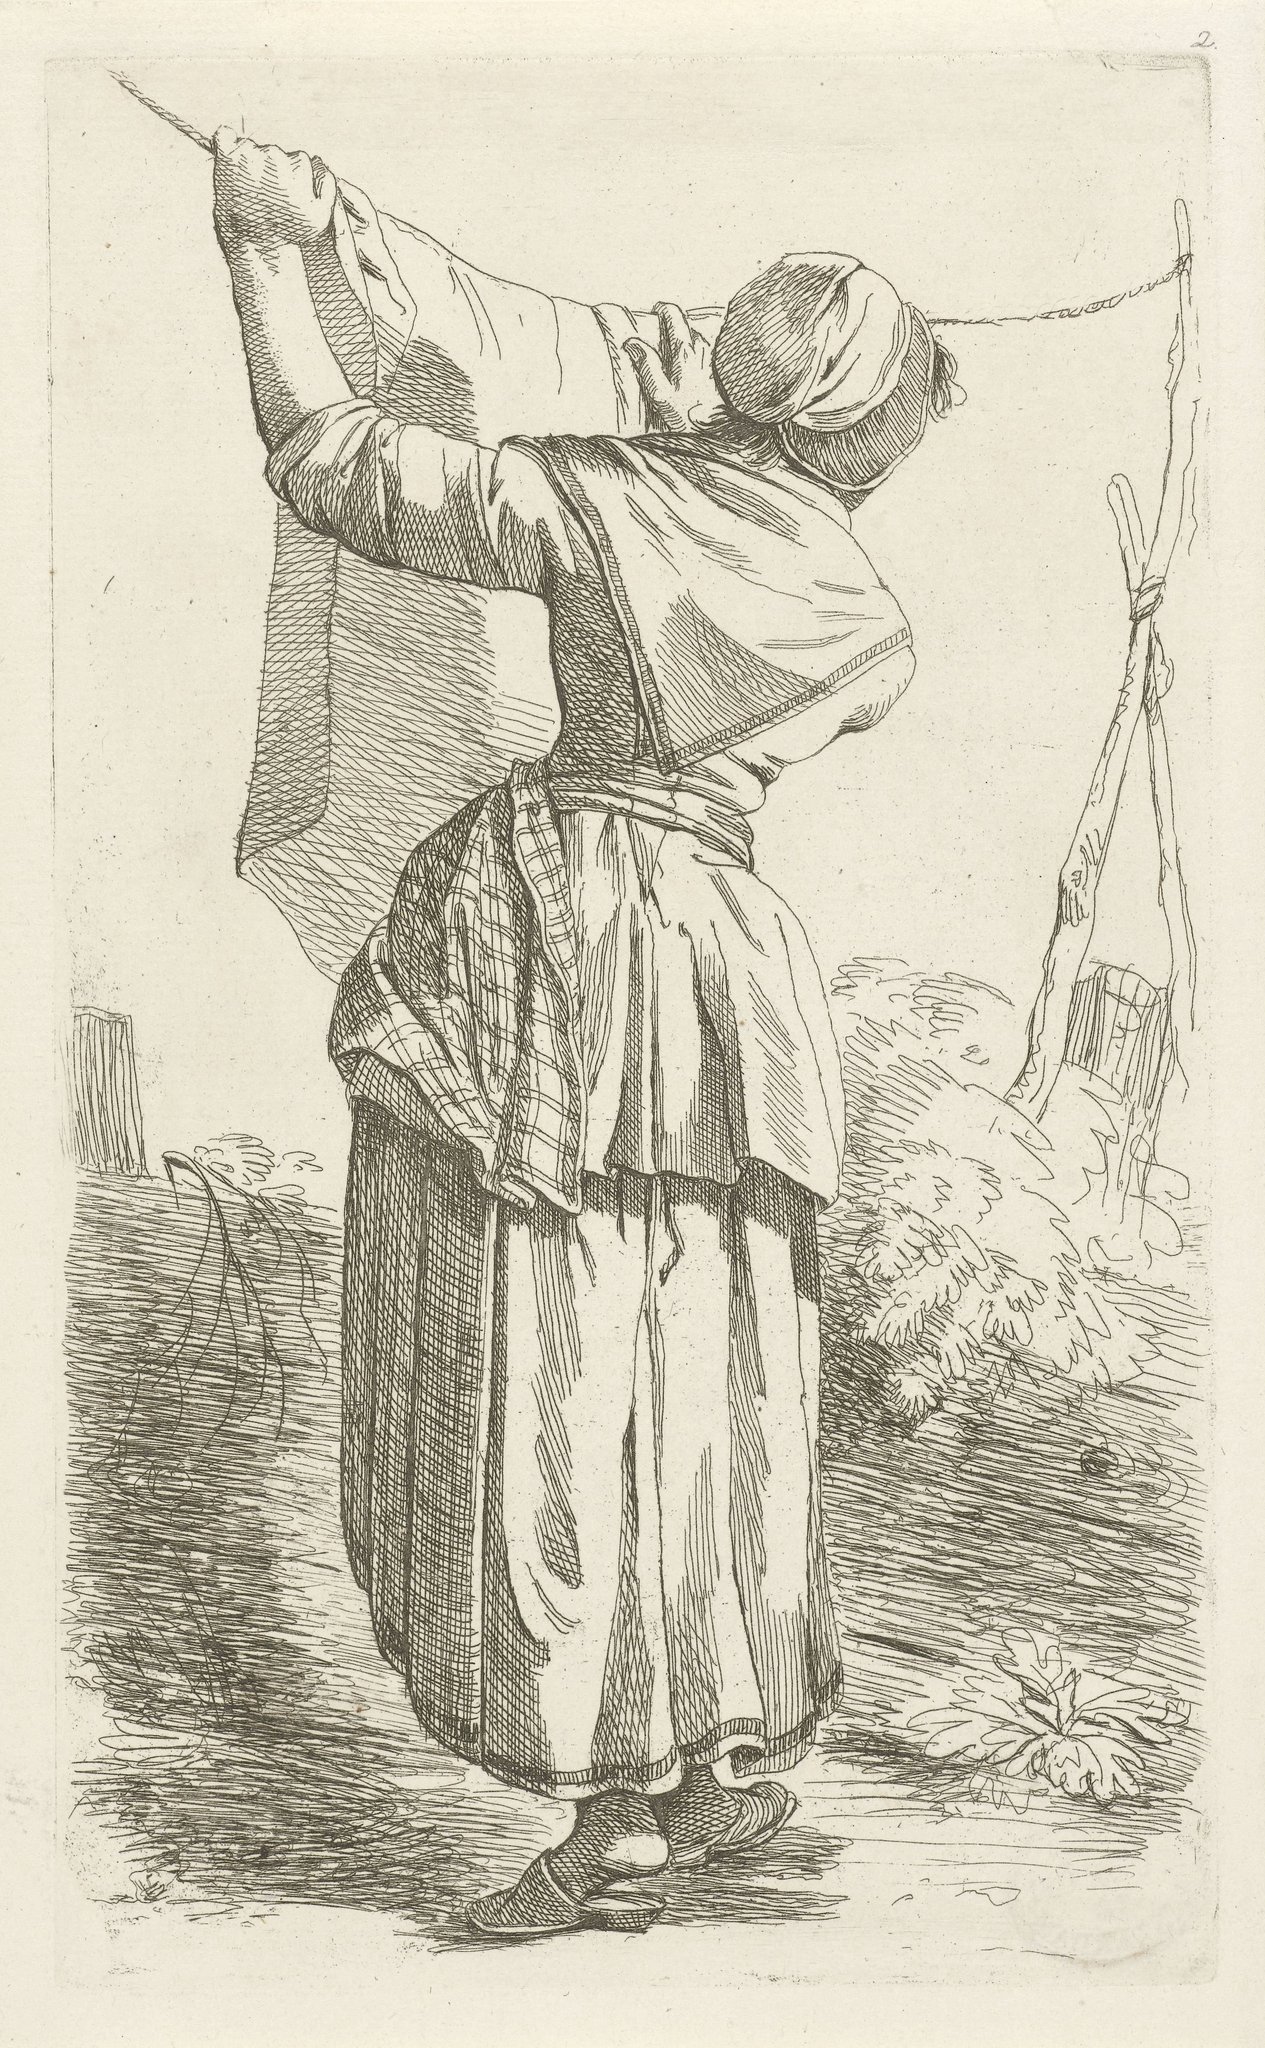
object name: print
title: Boerin bij een waslijn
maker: johannes pieter de frey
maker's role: draughtsman, print maker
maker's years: 1770-1834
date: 1770-1834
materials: paper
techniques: etching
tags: farmers, hanging the wash to dry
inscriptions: number: ‘2’, collector's mark: Lugt 12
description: Een boerin, op de rug gezien en ten voeten uit, hangt een doek over een waslijn. Haar hoofd is bedekt met een kapje. Deze prent maakt deel uit van een serie etsen door prentmaker J.P. de Frey naar tekeningen van J. Lauwers.